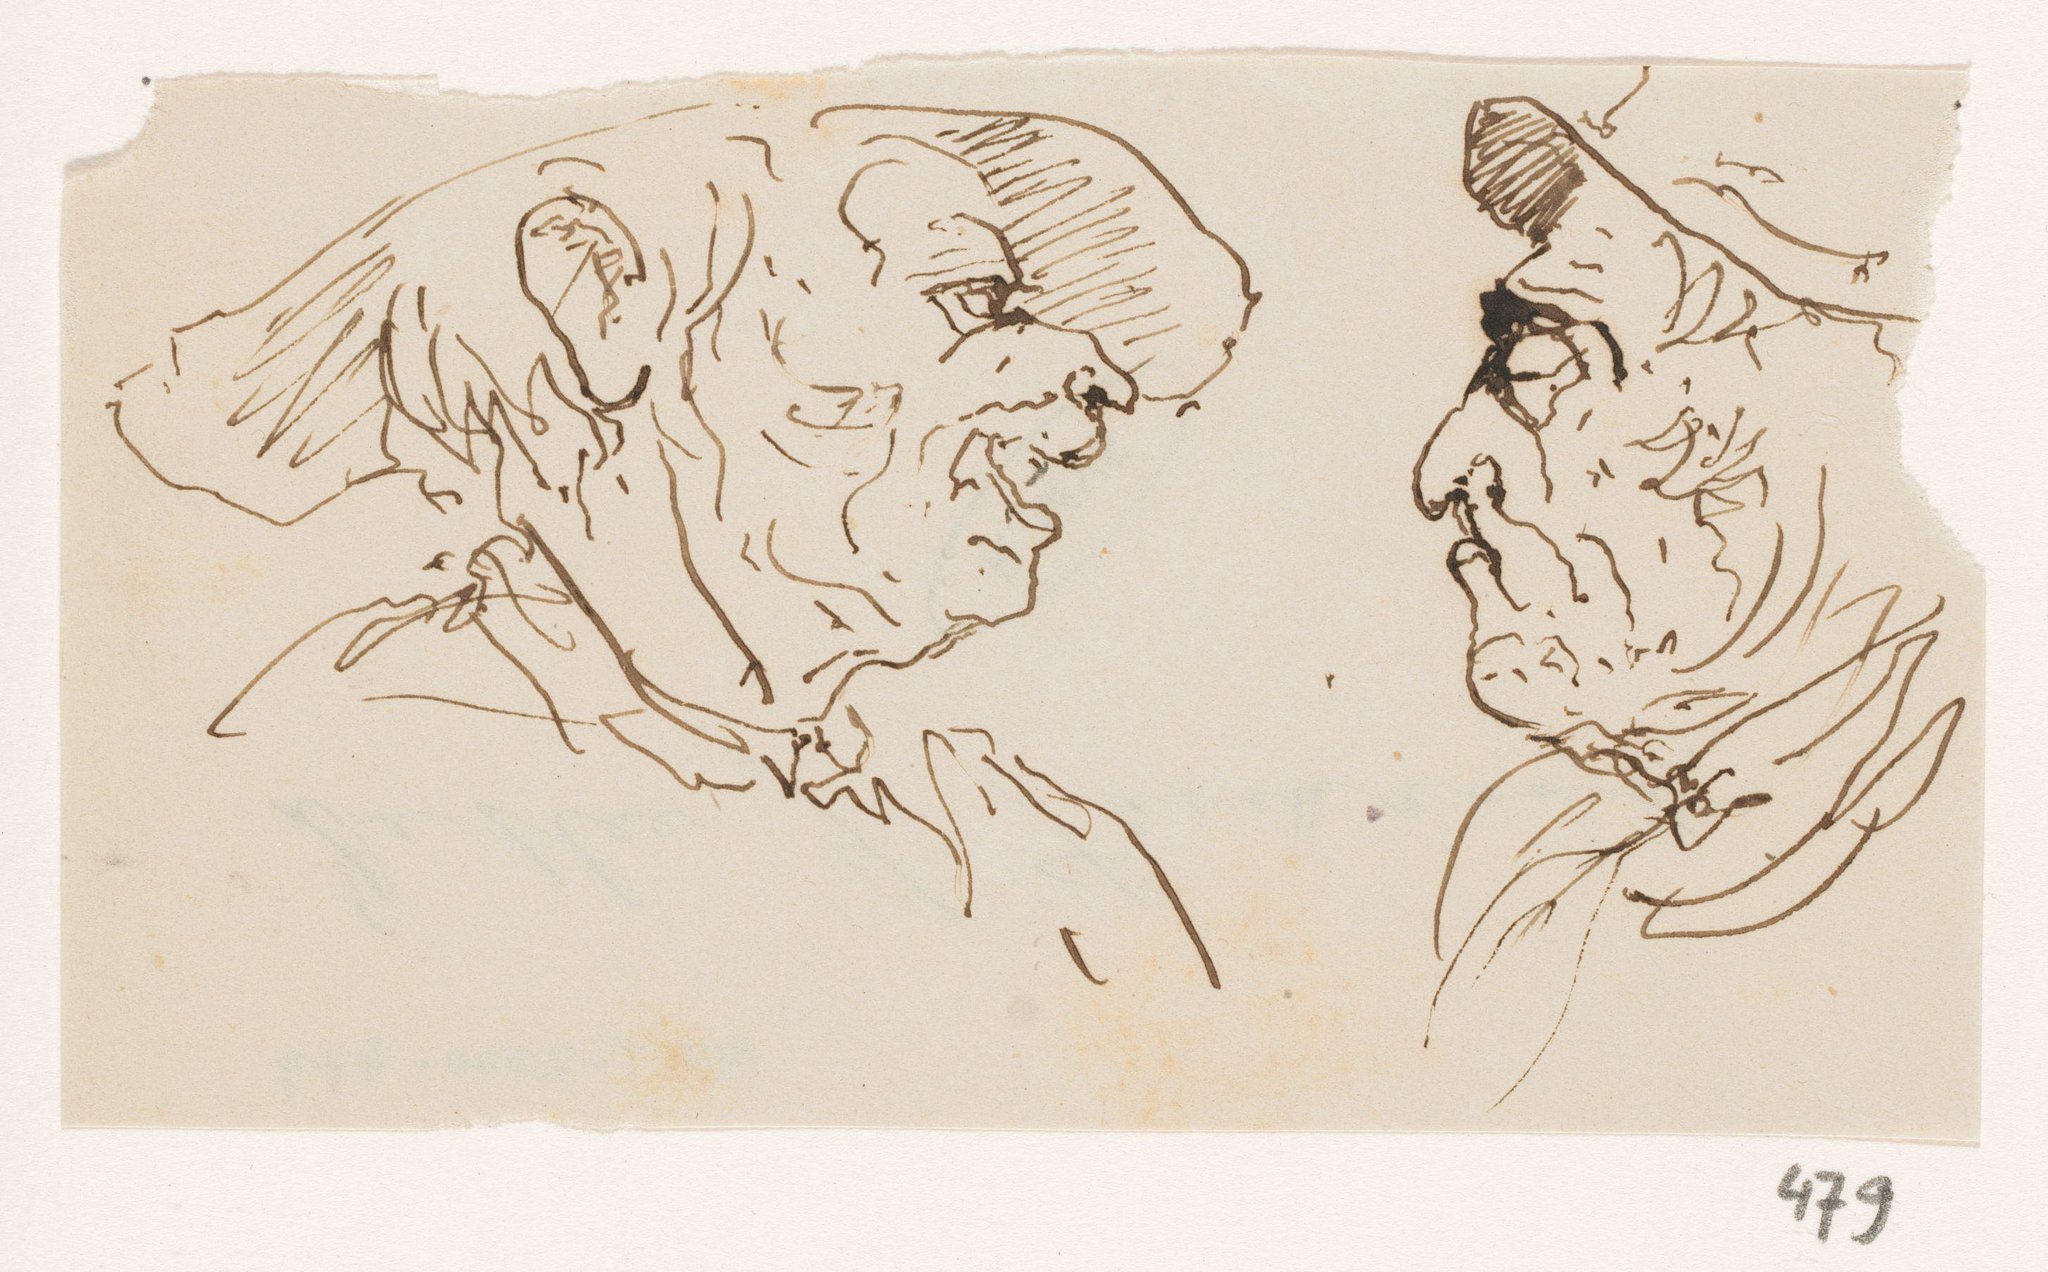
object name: drawing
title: Twee koppen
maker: johannes tavenraat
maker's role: draughtsman, painter, print maker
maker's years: 1809-1881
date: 1840-1880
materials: ink, paper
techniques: pen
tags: caricatures (human types)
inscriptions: collector's mark: Lugt 2228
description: Twee koppen. Getekend op de achterzijde van een fragment van een brief of envelop gericht aan J. Tavenraat.